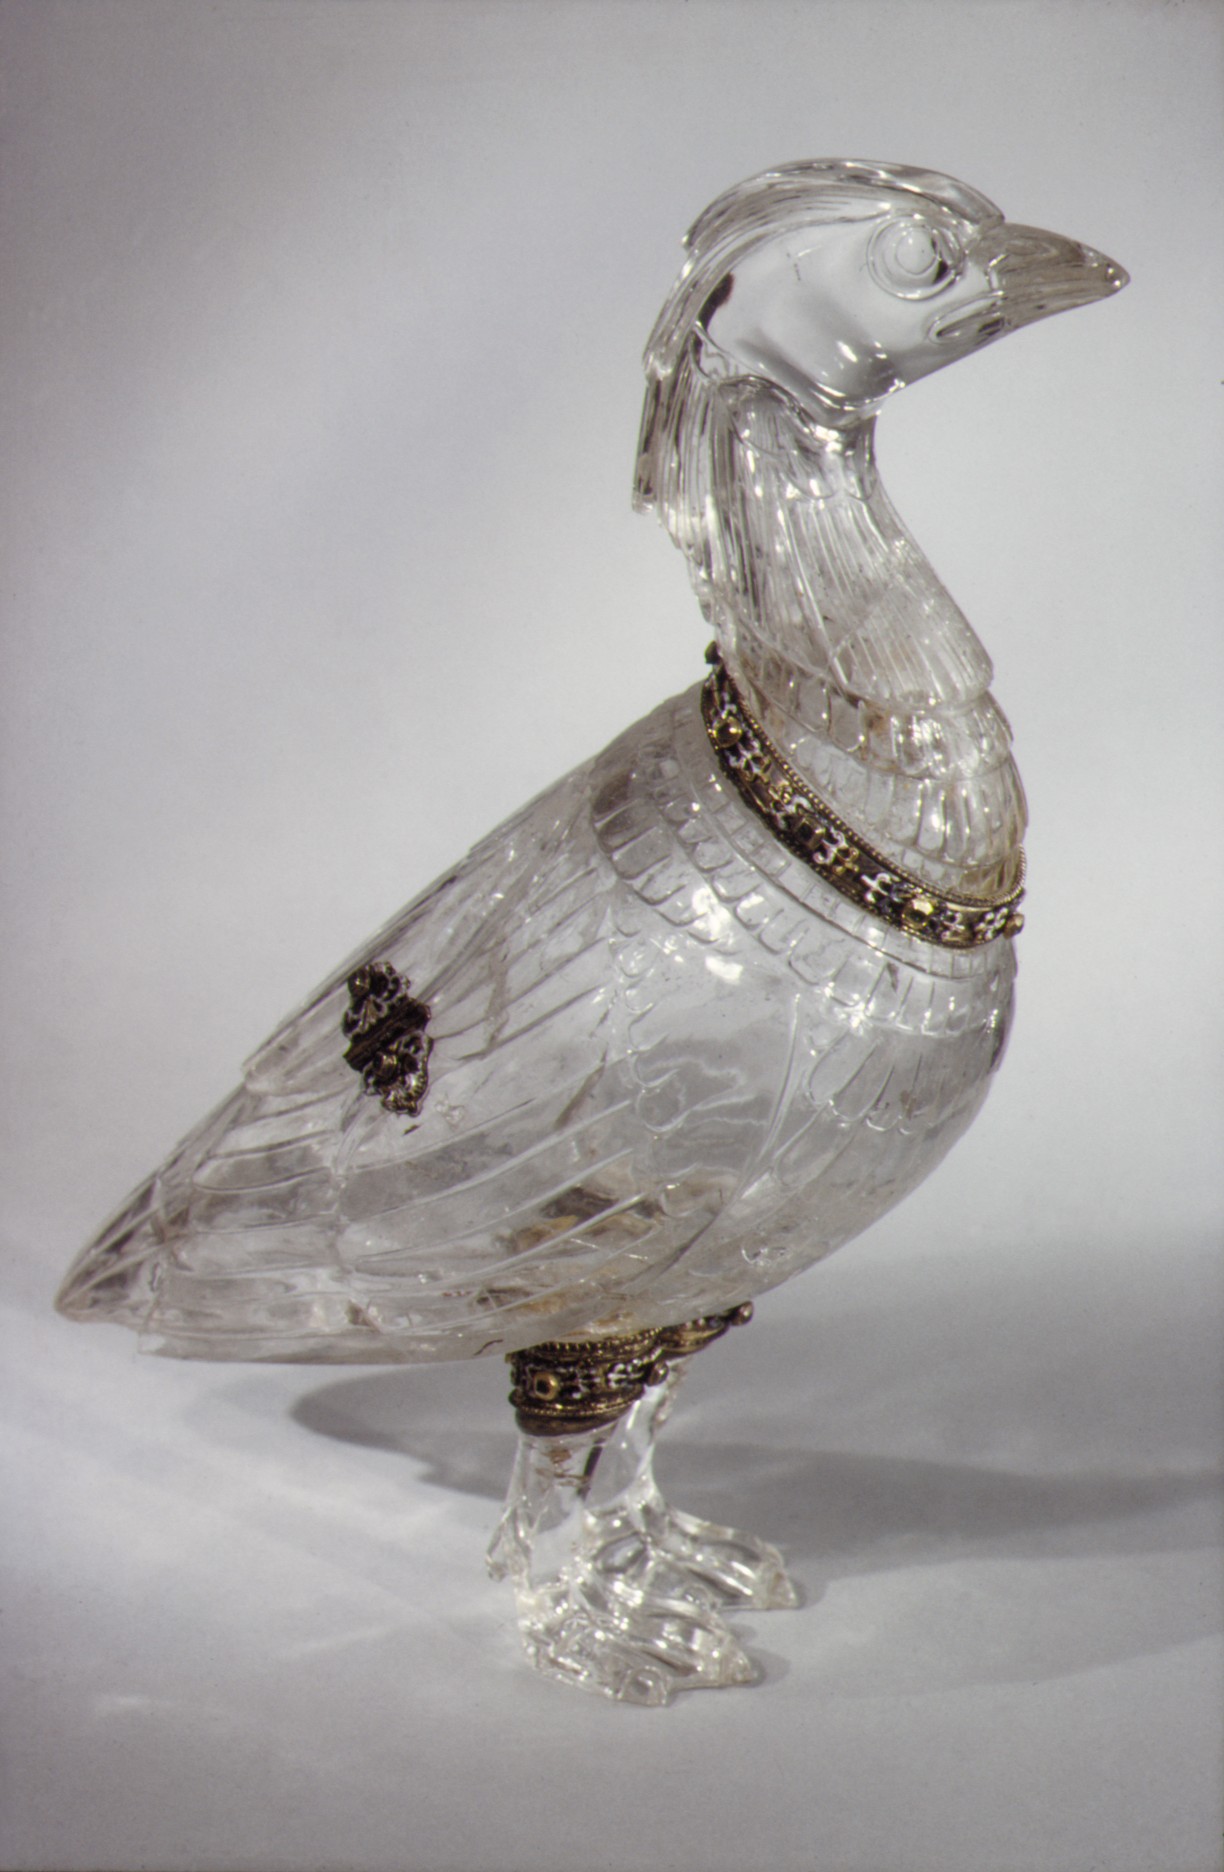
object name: vessel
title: Vessel in the form of a bird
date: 1567-1600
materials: brass, crystal, gilt, silver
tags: birds